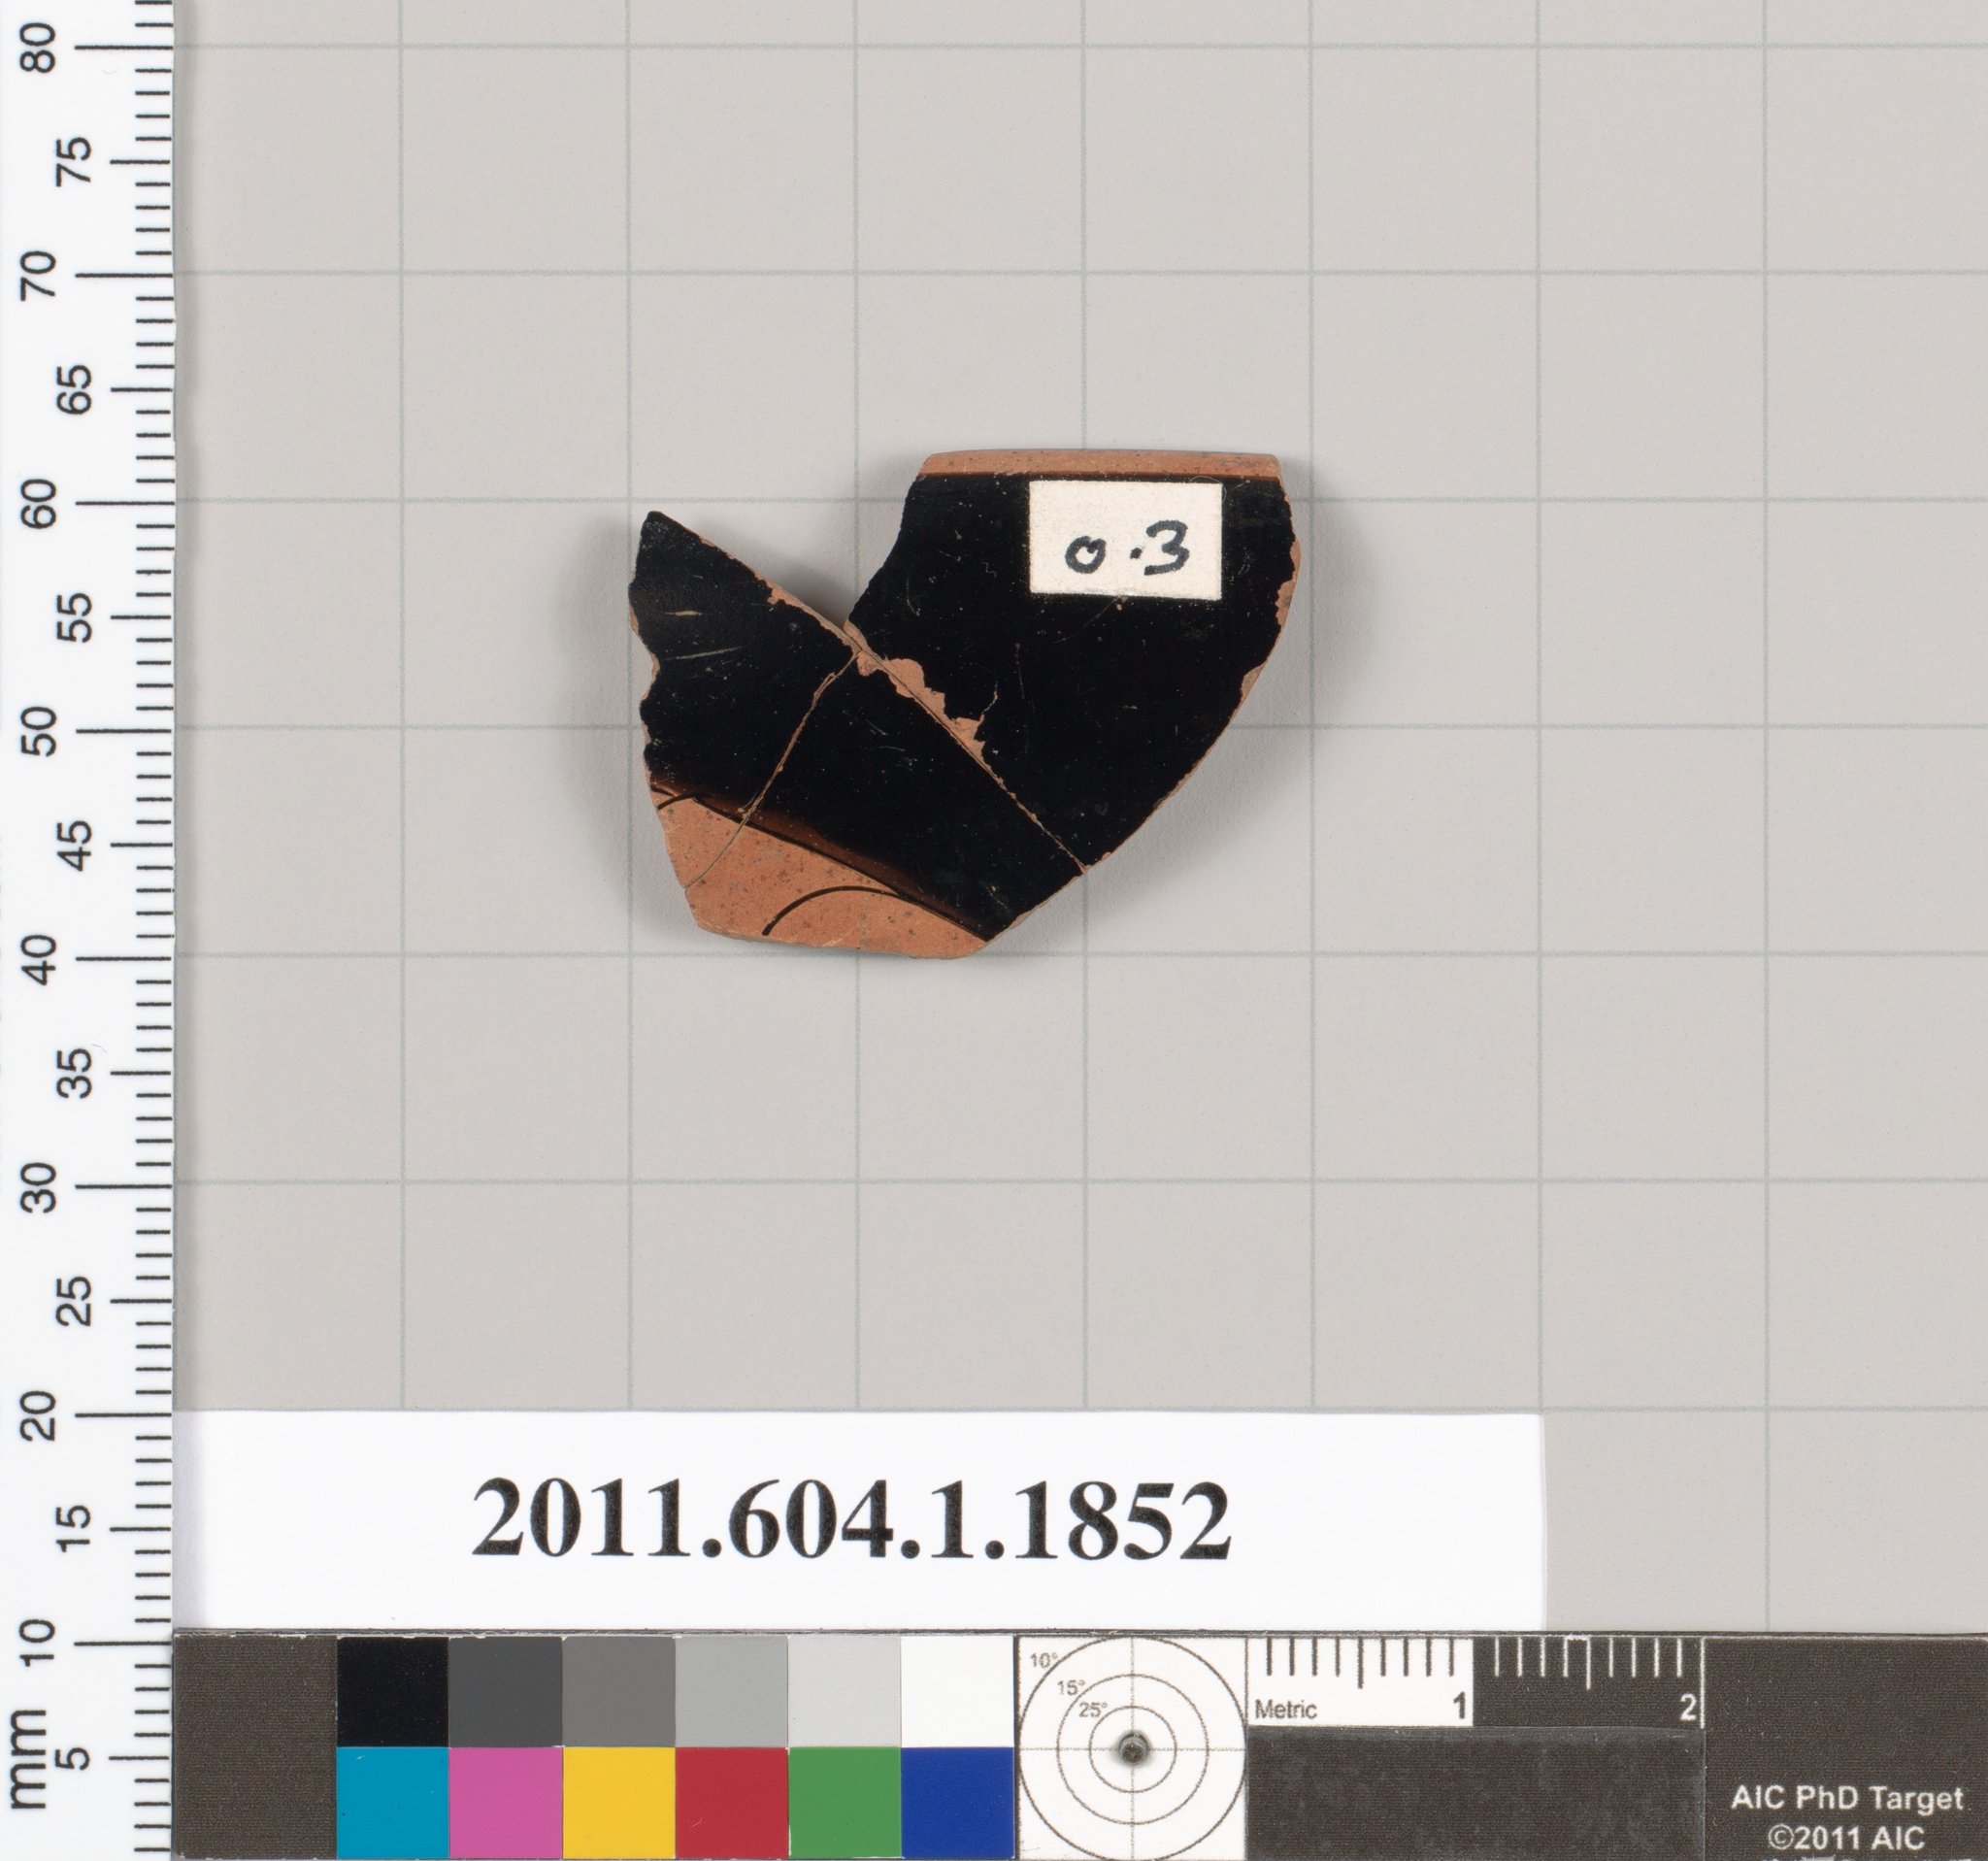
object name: kylix fragment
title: Terracotta rim fragment of a kylix (drinking cup)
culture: greek, attic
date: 475-451 BCE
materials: terracotta